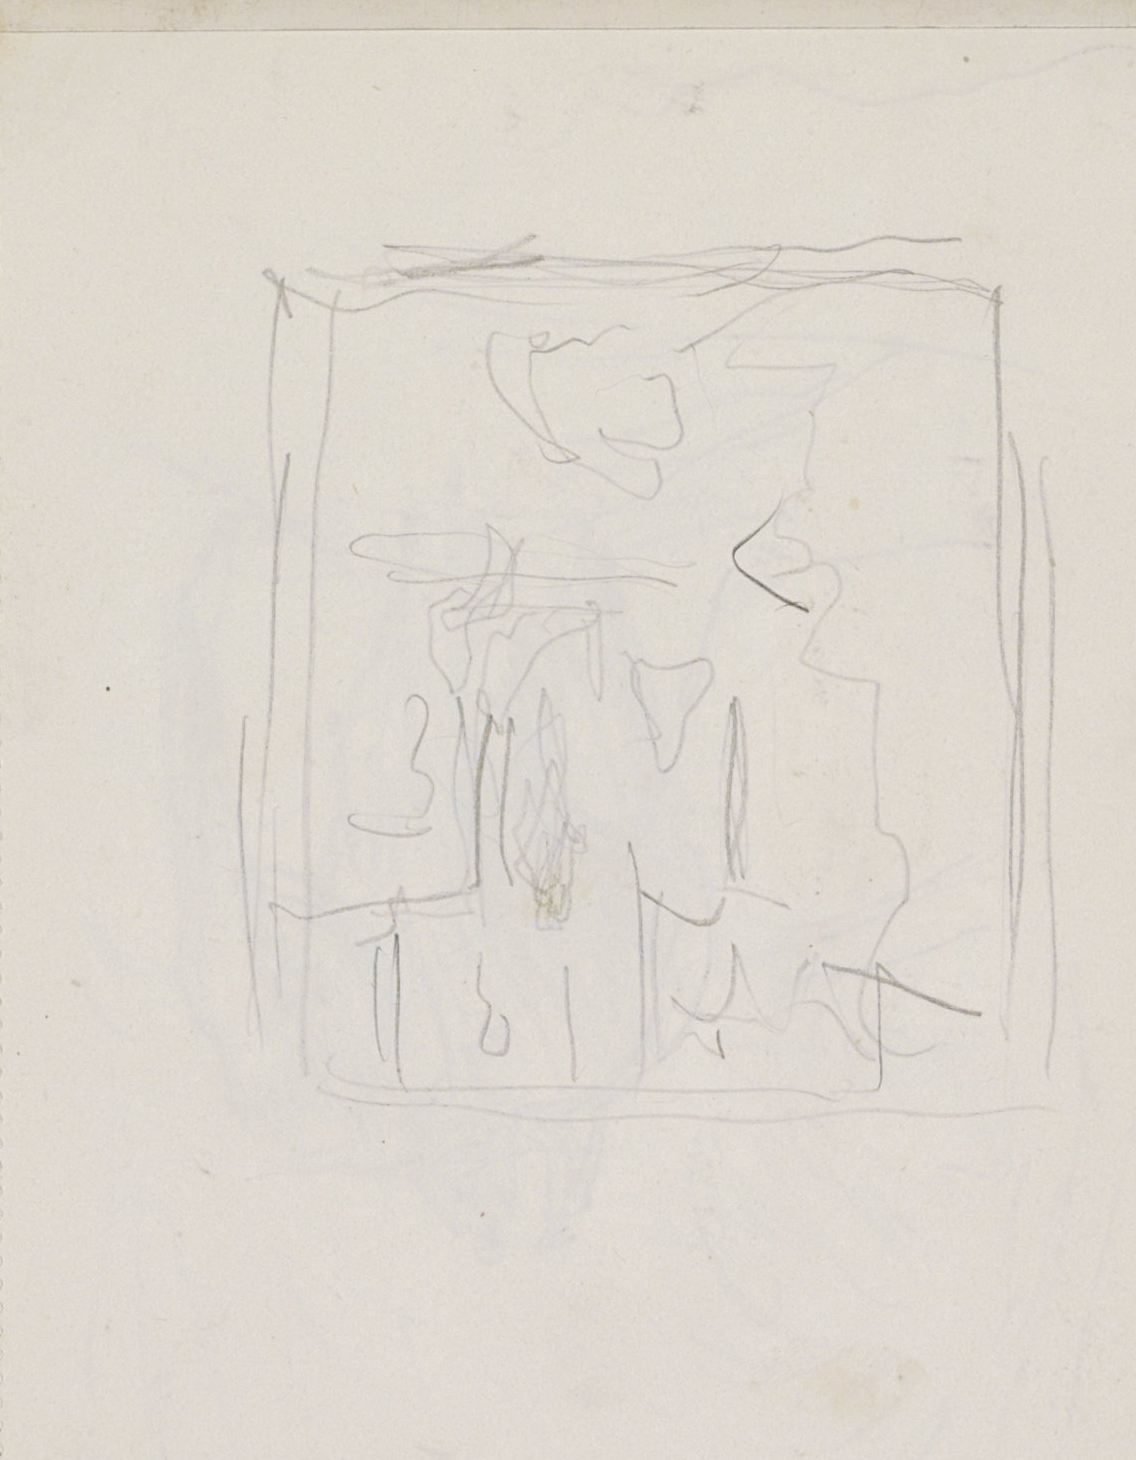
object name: sketchbook leaf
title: Figuren op een trap bij een gebouw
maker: marius bauer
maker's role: draughtsman, print maker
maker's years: 1867-1932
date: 1924-1925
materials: paper, pencil, watercolor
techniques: brush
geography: india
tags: sitting figure, flight of steps, architecture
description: Pagina 143 uit een schetsboek met 75 bladen.